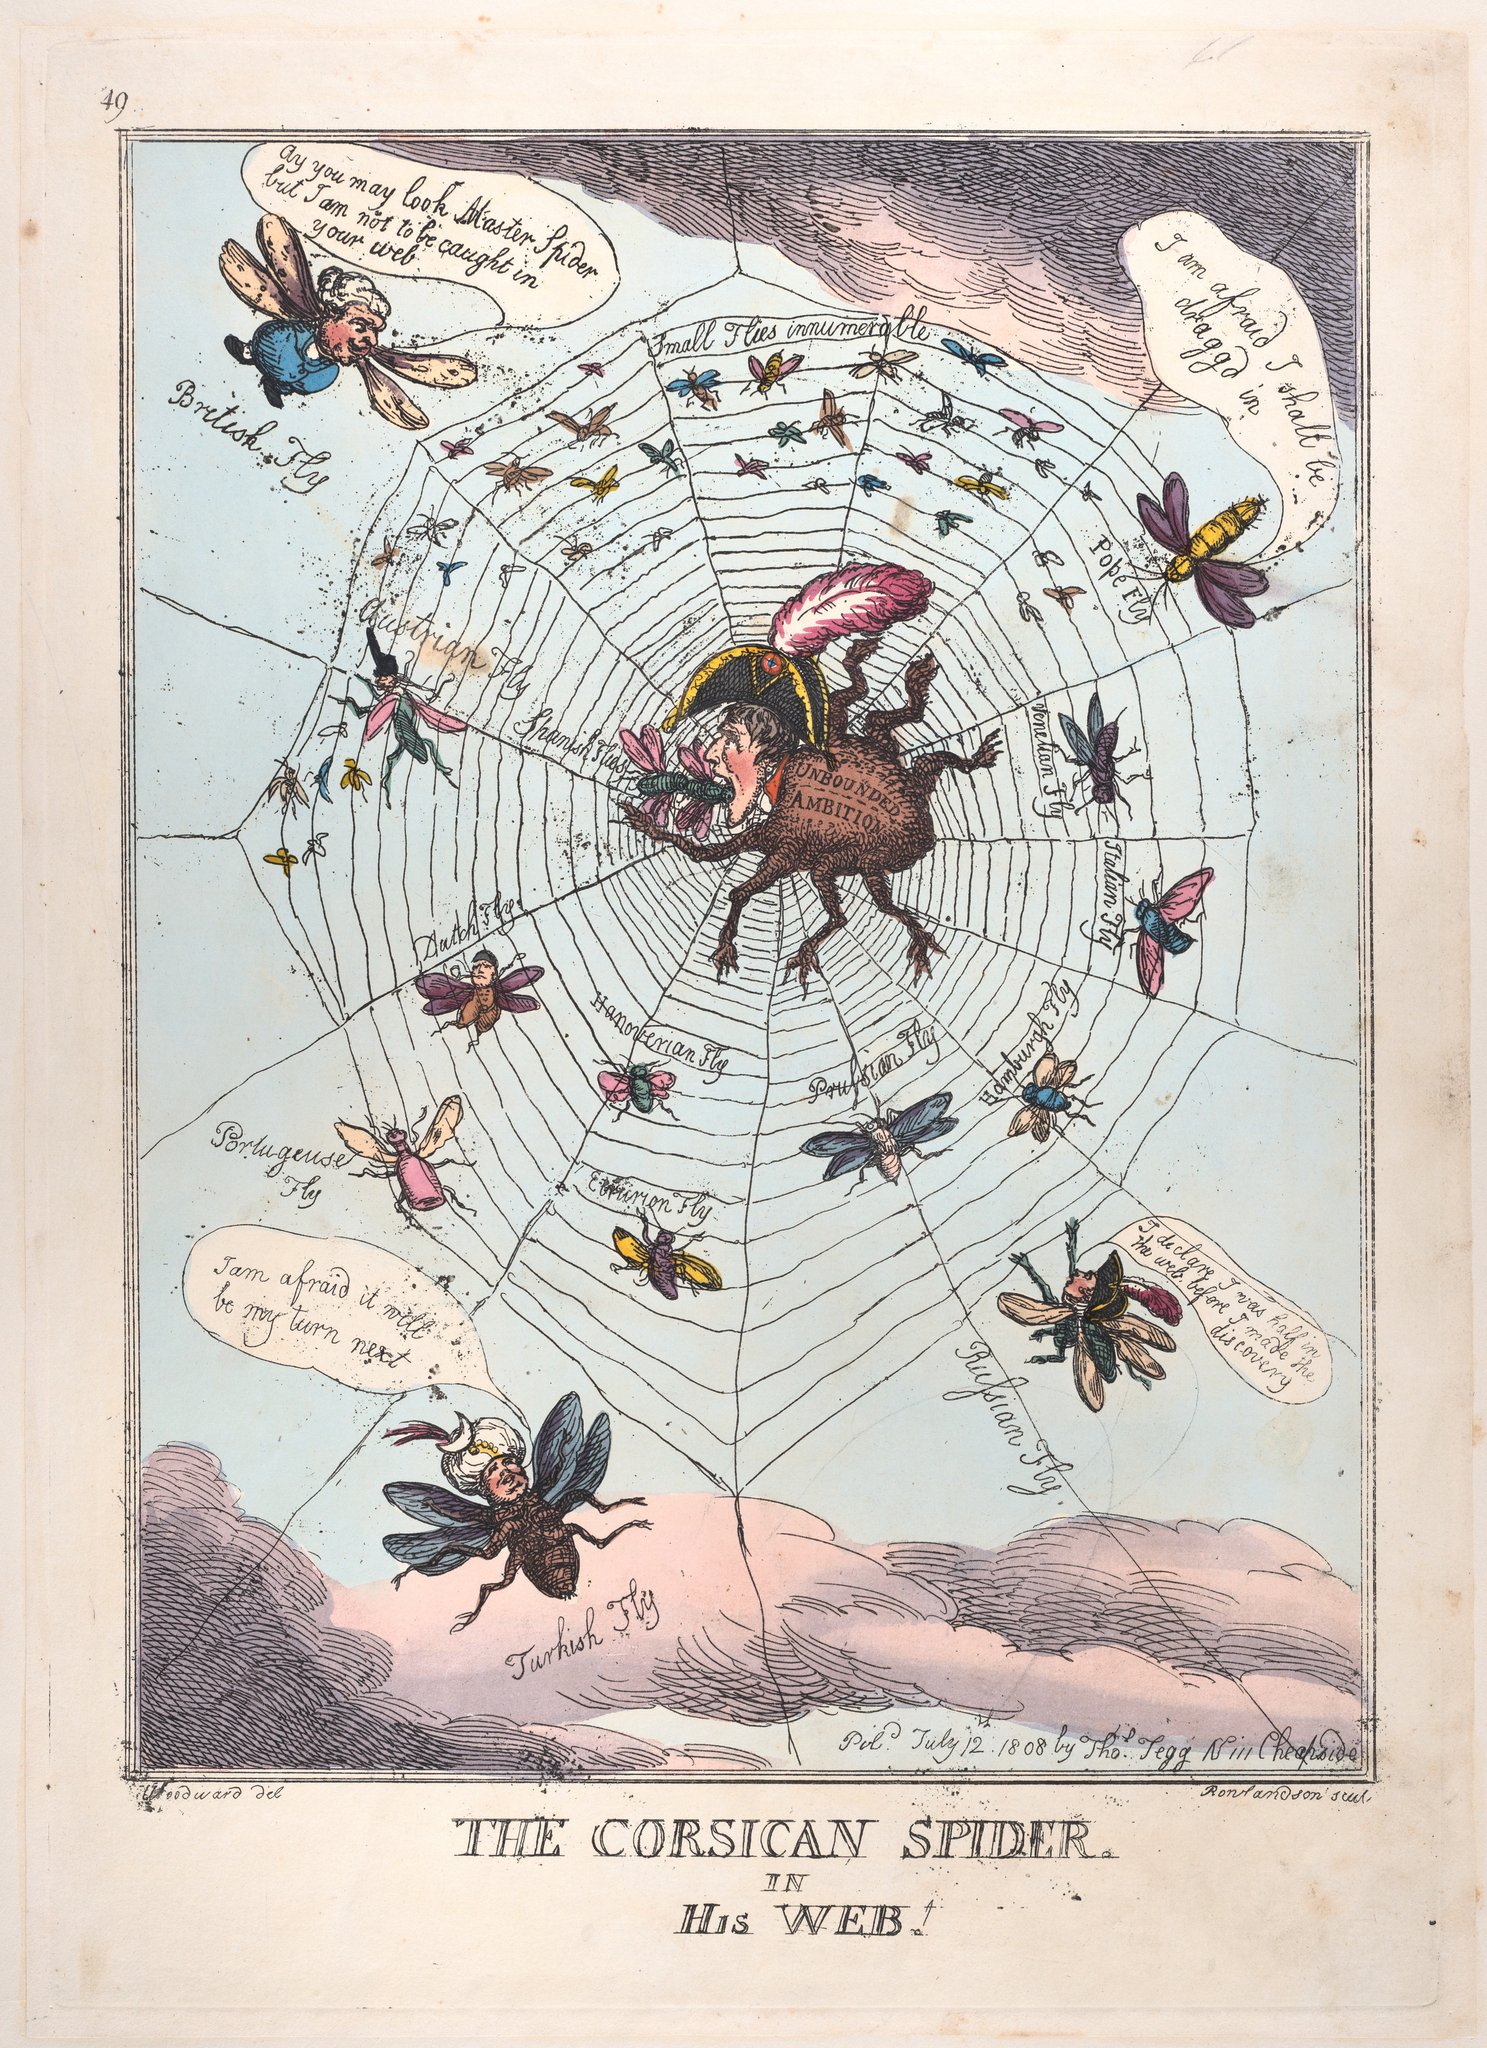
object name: print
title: The Corsican Spider in His Web!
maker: thomas rowlandson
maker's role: artist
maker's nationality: british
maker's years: 1757-1827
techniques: etching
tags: satire,napoleon i,insects,spiders,politics